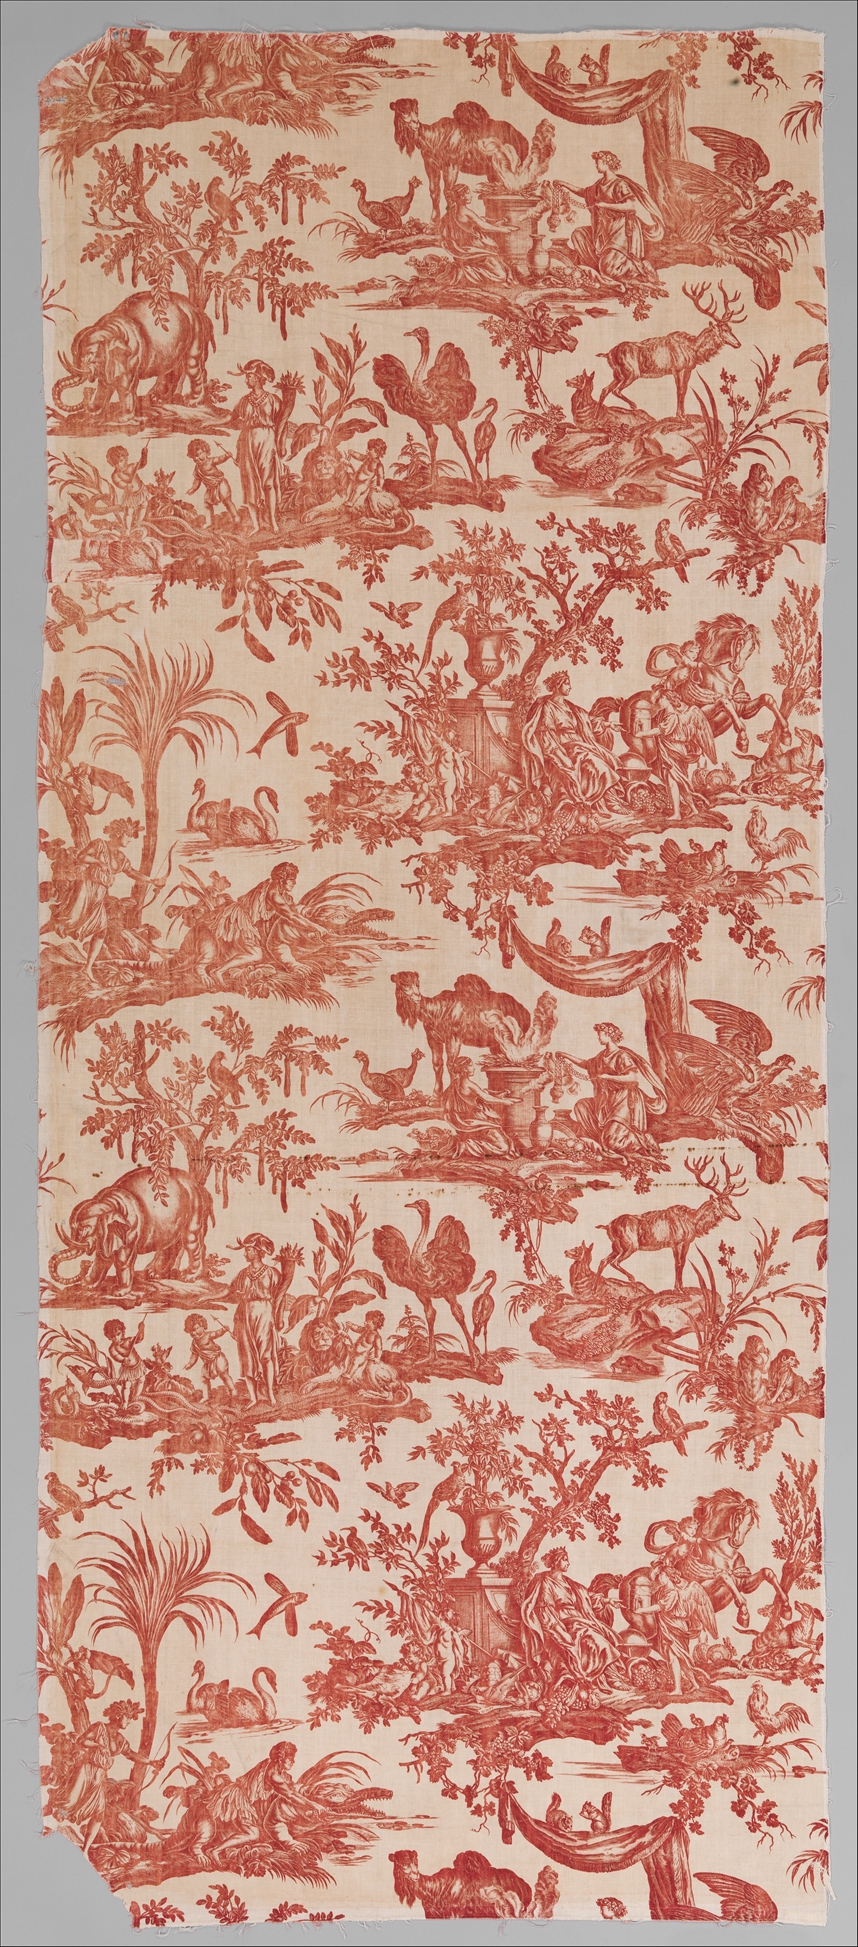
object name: panel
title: "Four Parts of the World"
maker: jean-baptiste huet i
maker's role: designer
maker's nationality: french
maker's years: 1745-1811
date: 1788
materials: cotton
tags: birds,deer,elephants,horses